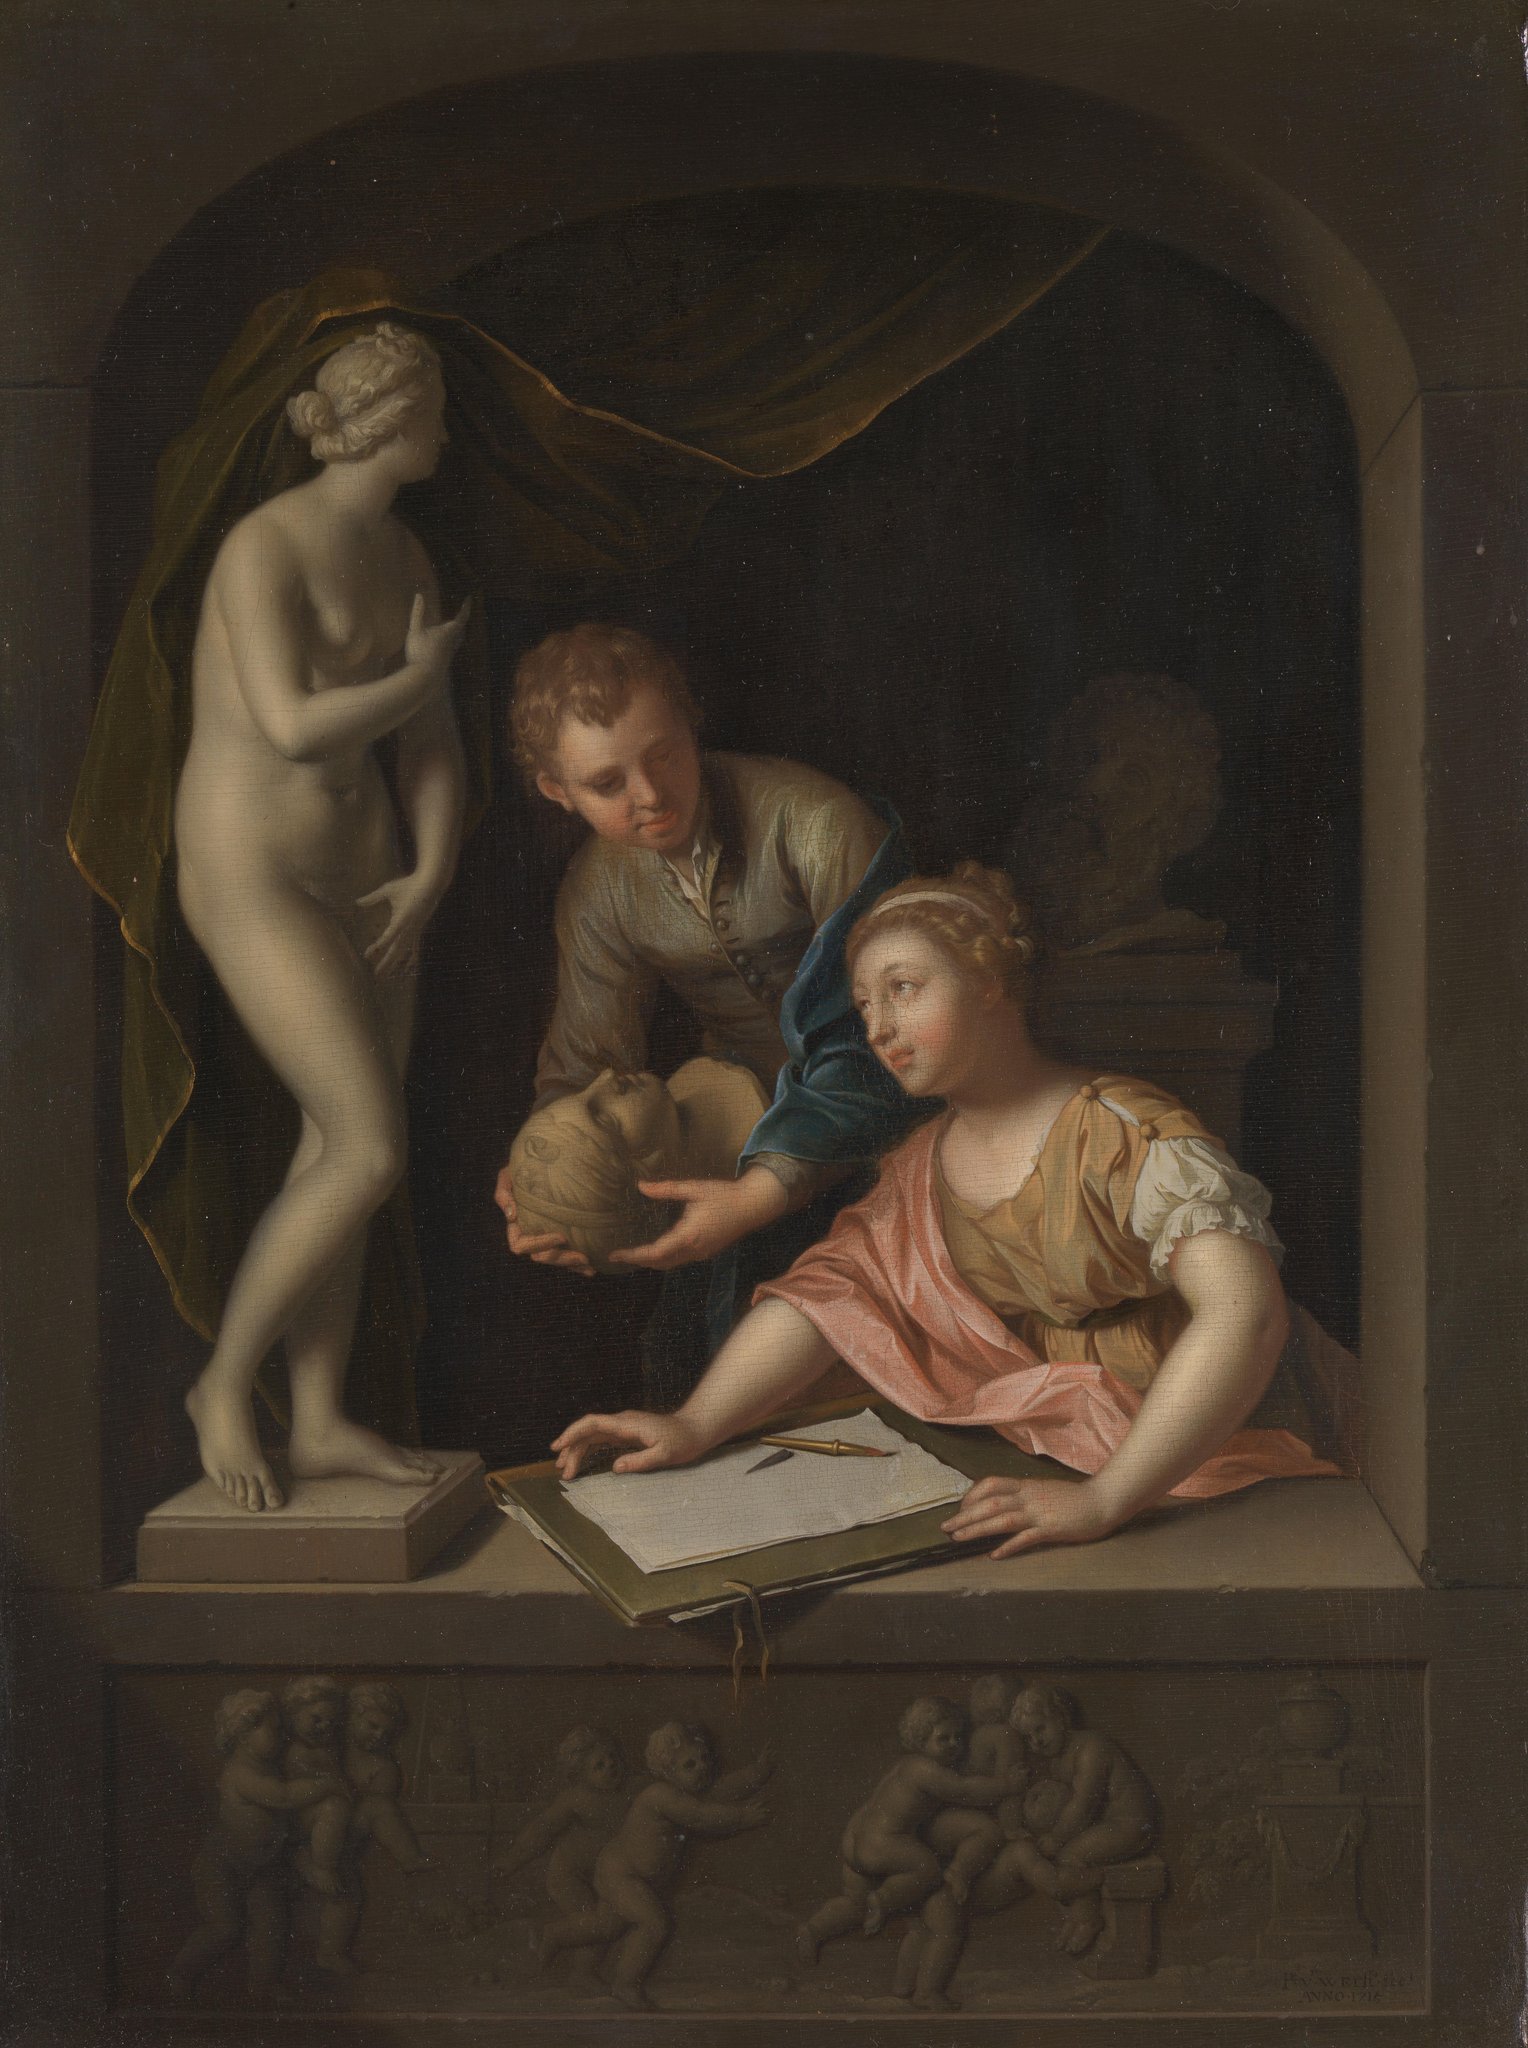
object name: painting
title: A Girl Drawing and a Boy near a Statue of Venus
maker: pieter van der werff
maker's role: draughtsman, painter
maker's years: 1665-1722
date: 1715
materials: oil, panel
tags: piece of sculpture, reproduction of a piece of sculpture, (story of) venus (aphrodite), cupids: 'amores', 'amoretti', 'putti', draughtsman studying classical remains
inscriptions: signature and date: ‘P. v.r Werff. fec.t Anno 1715’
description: The girl is drawing a statue, a copy of the famous Venus Medici, a Classical sculpture in the Uffizi in Florence. The young artist also has other models at her disposal: the boy shows her a head of Venus and in the background is the head of a Greek philosopher. The plinth is filled with a painted rendering of a marble relief of children (putti) at play.